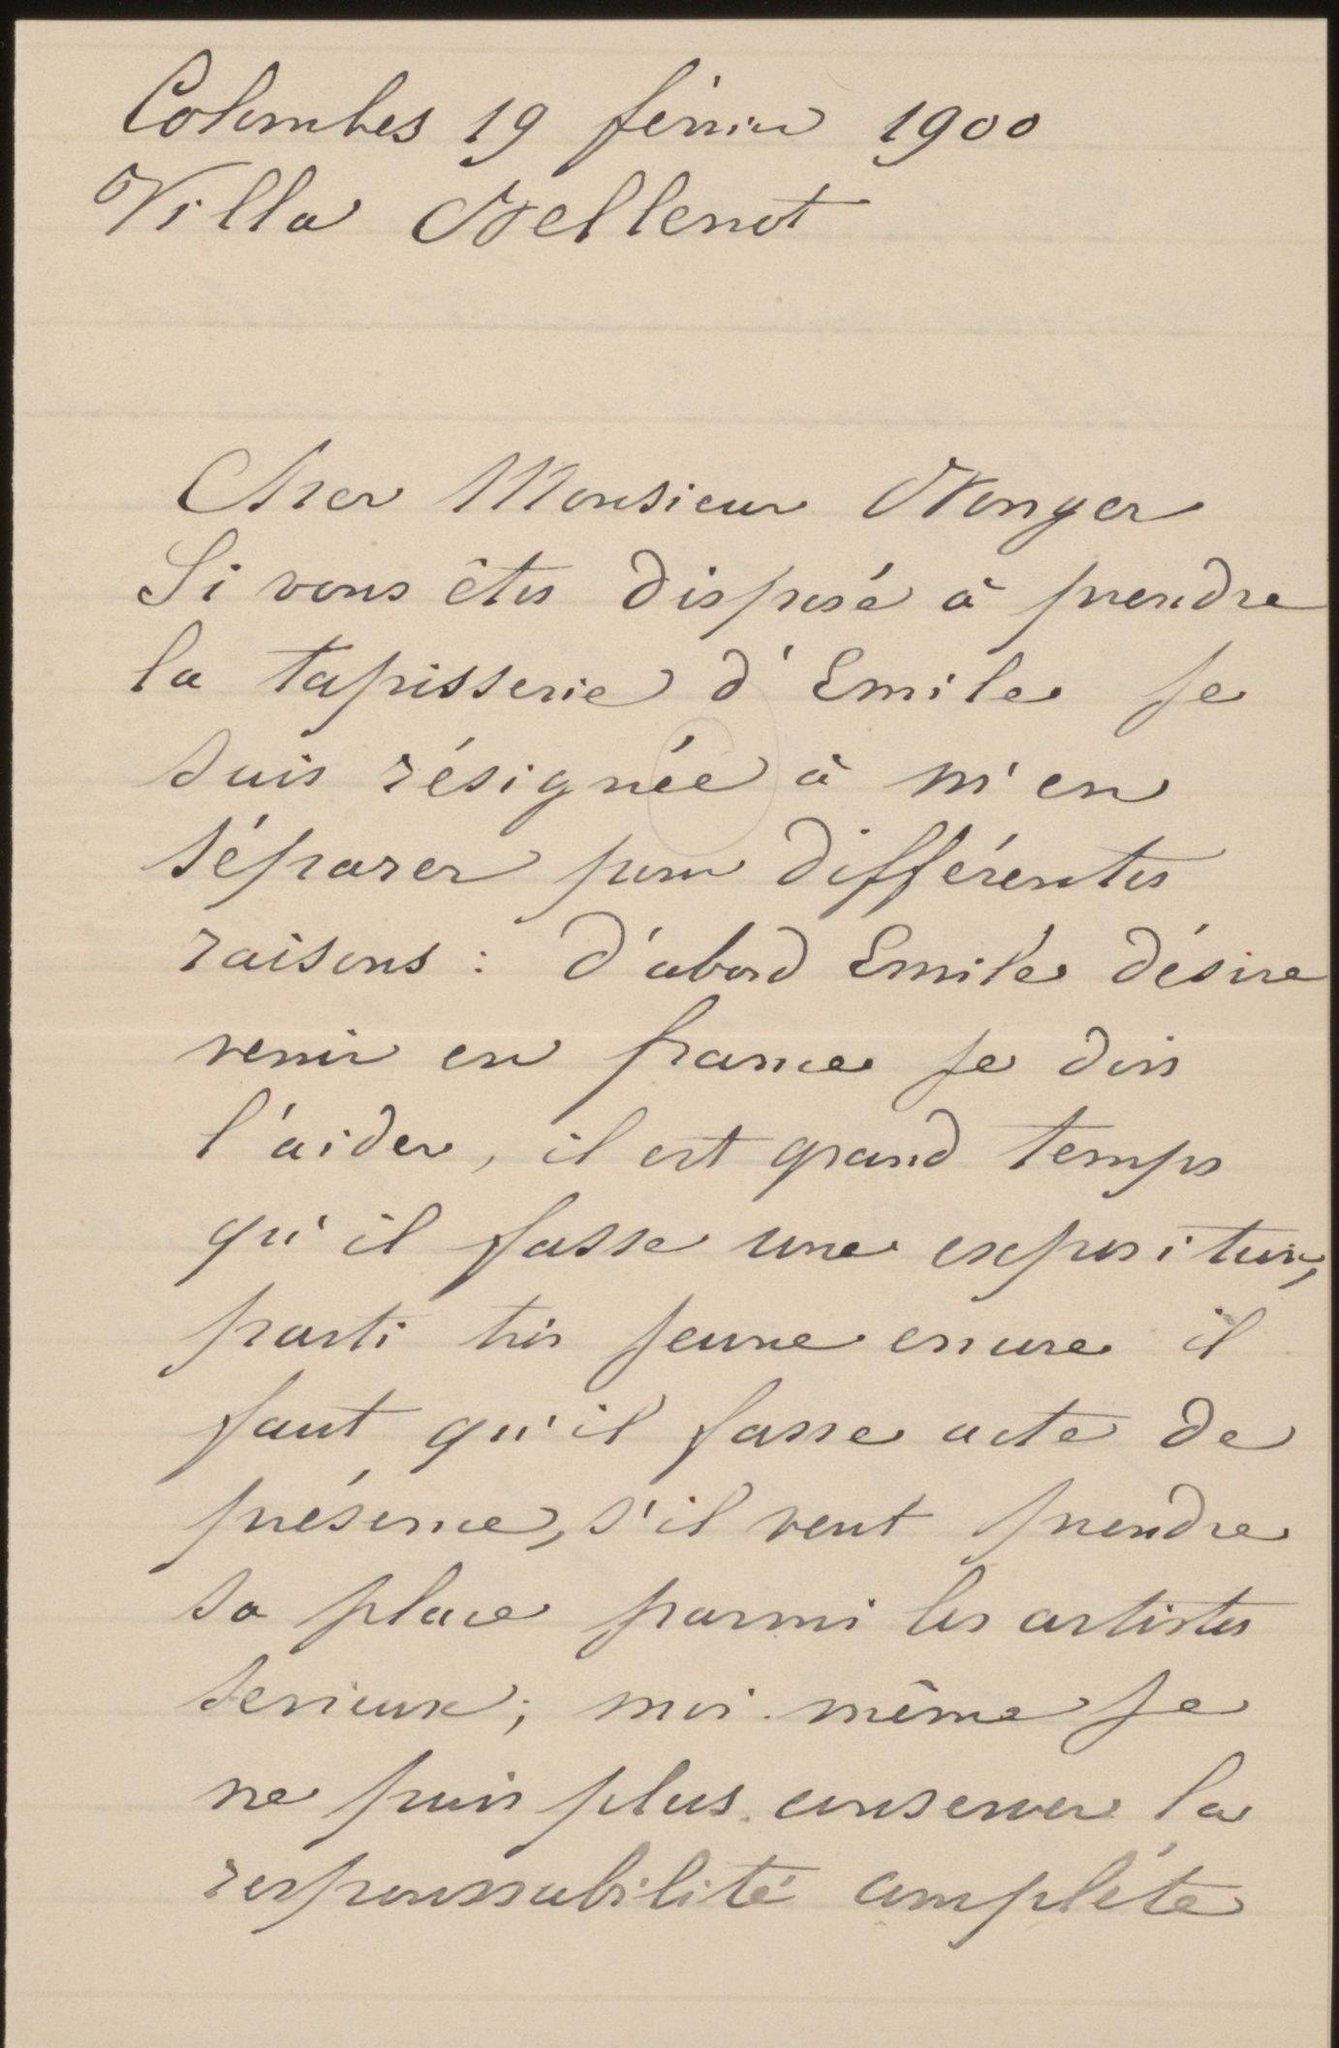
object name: letter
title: Brief aan Andries Bonger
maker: héloïse bernard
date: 1900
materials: ink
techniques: pen, writing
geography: colombes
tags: émile bernard, andries bonger, applied arts, arts and crafts; industrial design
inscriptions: watermark